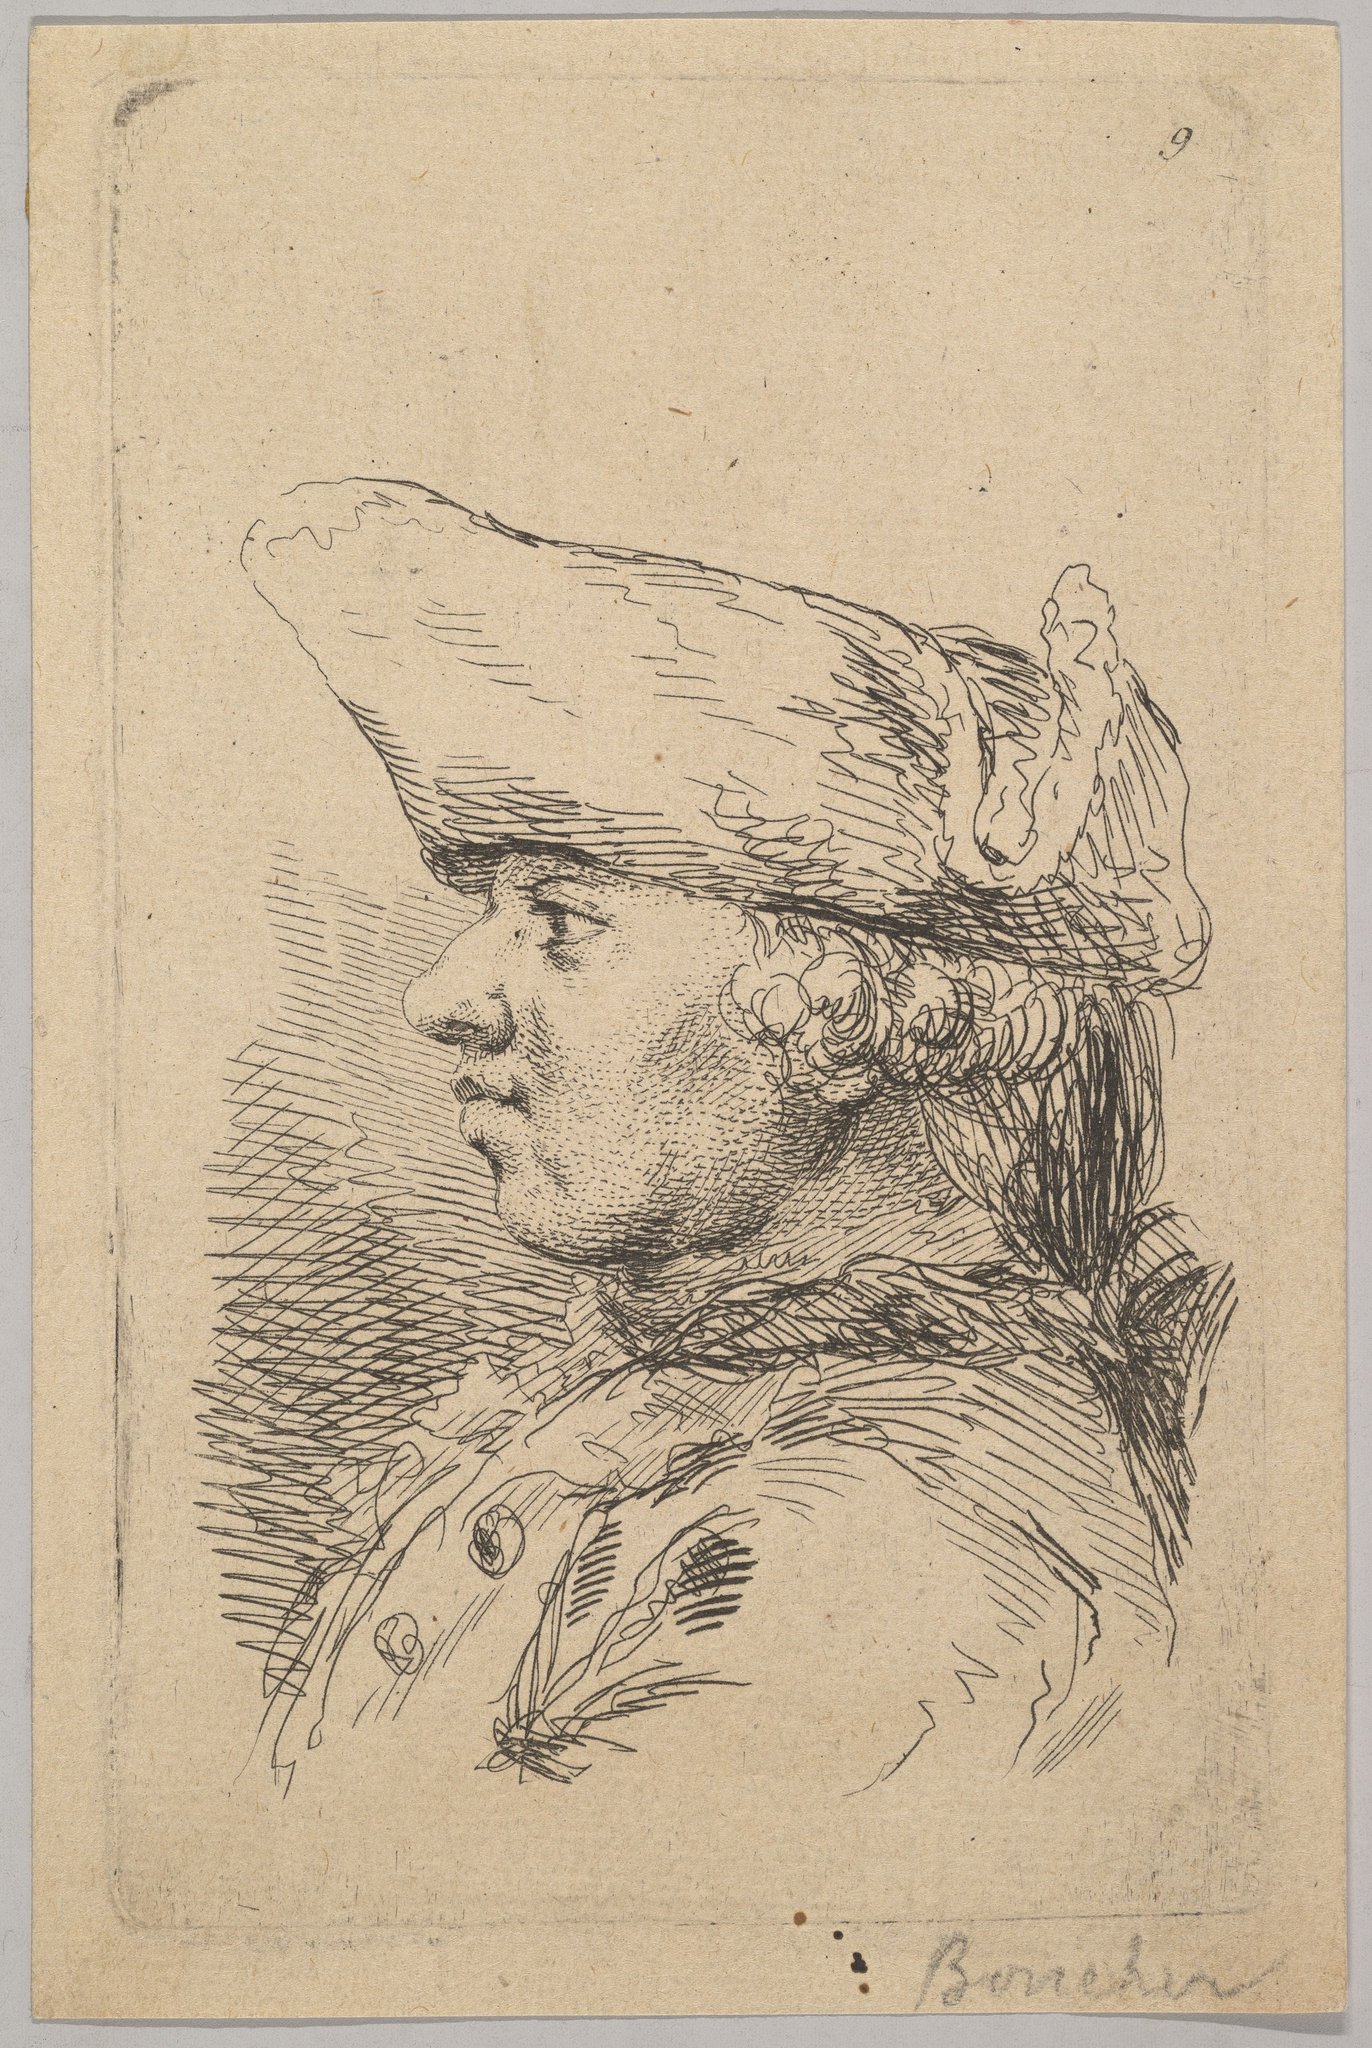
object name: print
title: Head of a man in profile wearing a tricorne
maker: anonymous, french, 18th century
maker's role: artist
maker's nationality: french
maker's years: 1700-1800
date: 1701-1800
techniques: etching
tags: tricorns,men,profiles